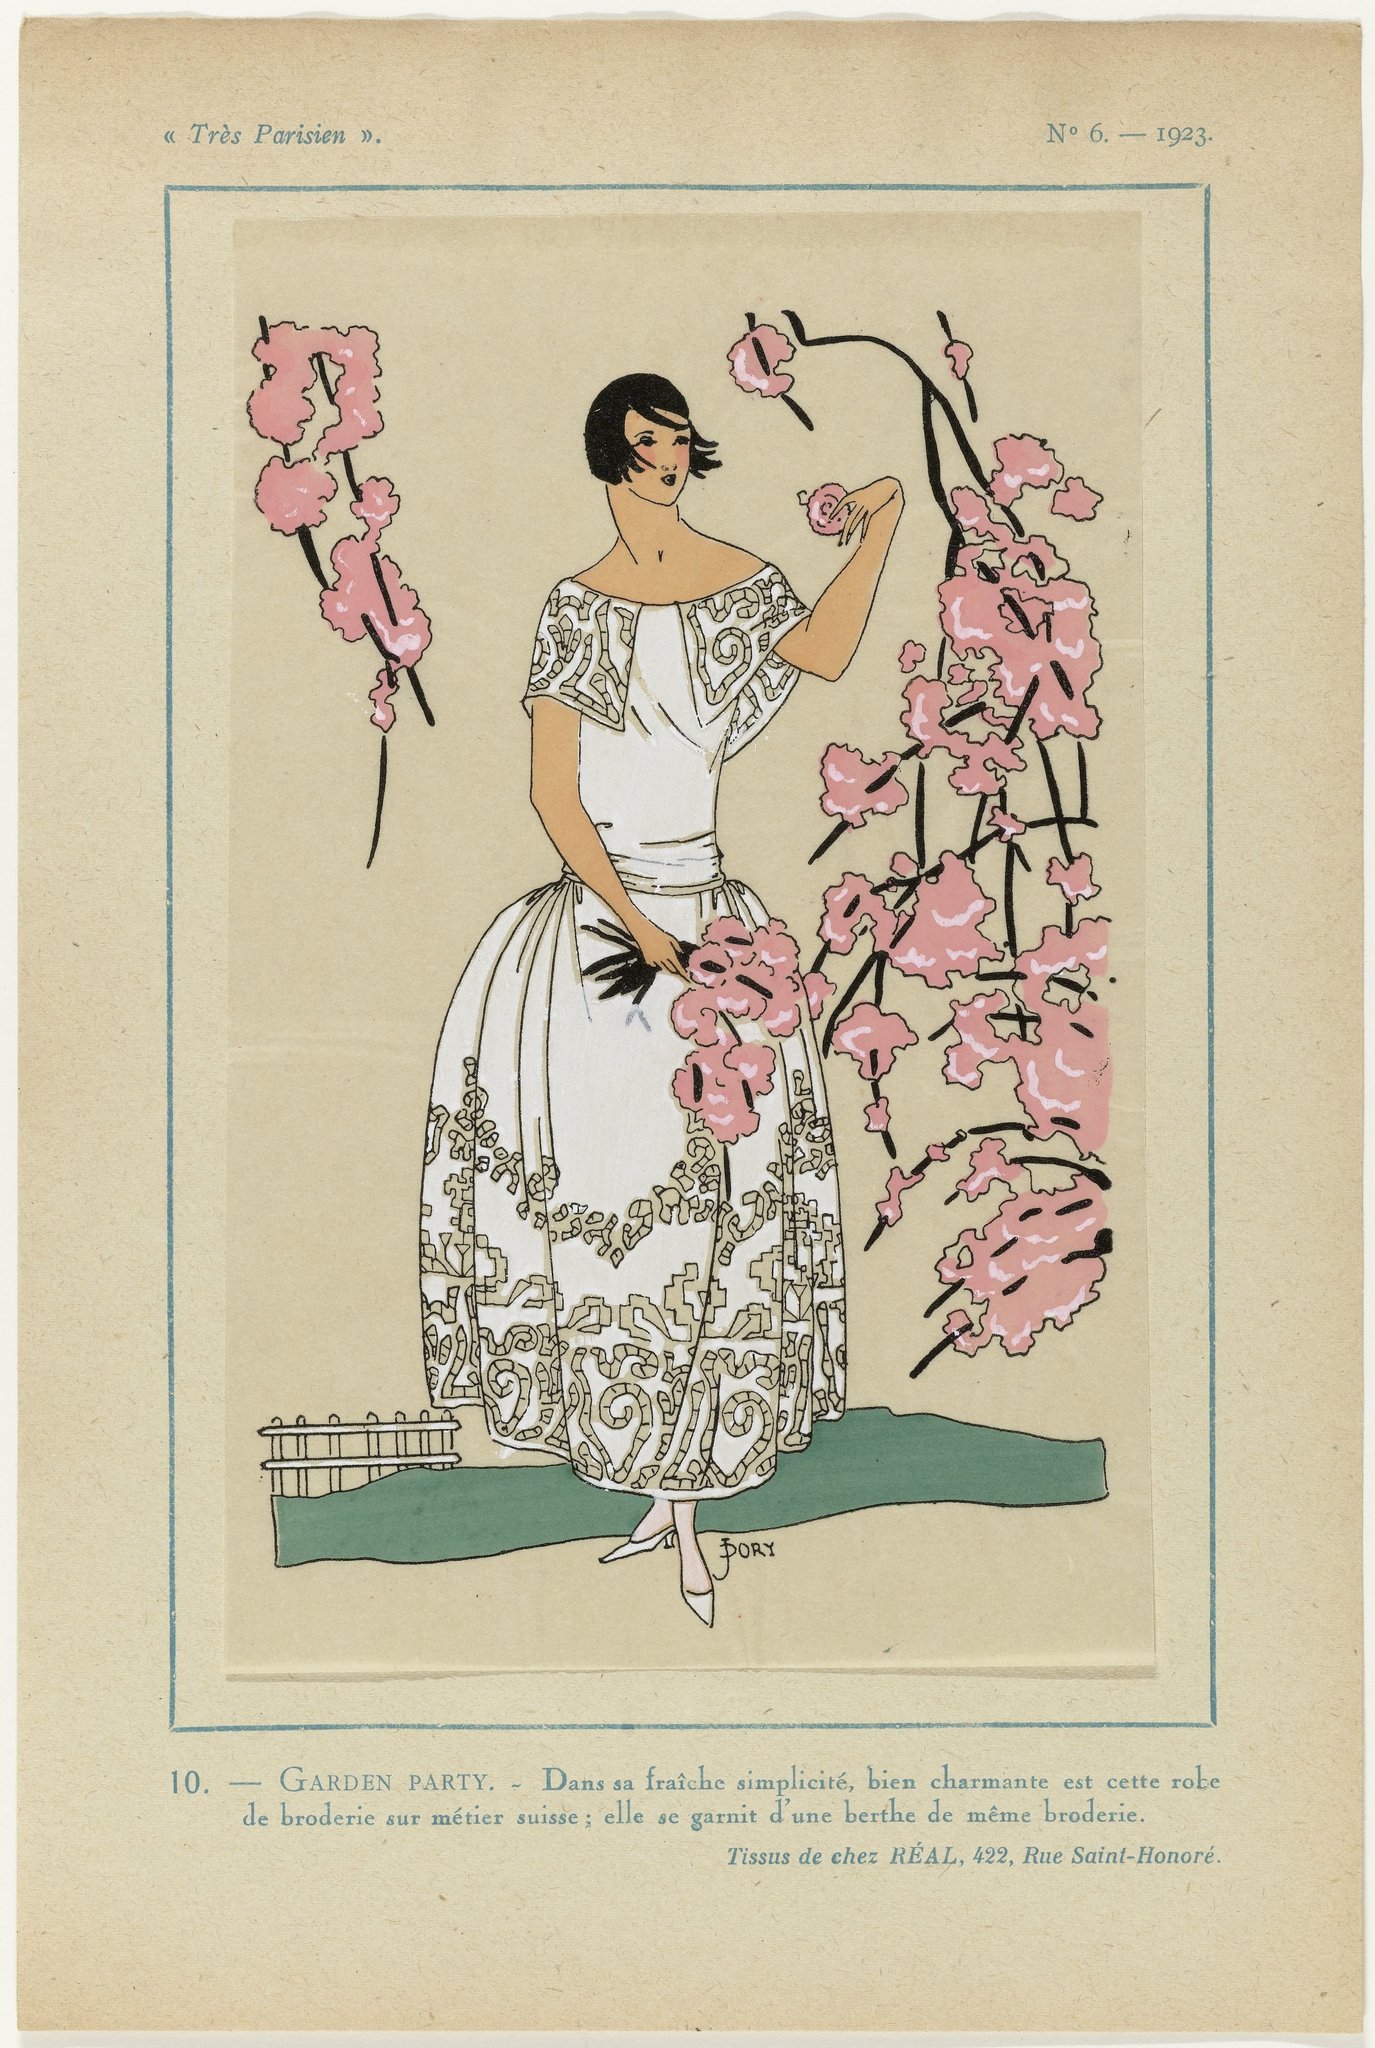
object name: fashion print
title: Très Parisien, 1923, No 6: 10. -GARDEN PARTY. - Dans sa fraîche...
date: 1923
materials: paper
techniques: hand coloring, letterpress printing, lithography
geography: paris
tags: picking flowers, embroidery (ornamentation) (+ women's clothes), neck-gear ~ clothing (bertha) (+ women's clothes), fashion plates, head-gear: hat (+ women's clothes), dress, gown (+ women's clothes)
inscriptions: title: ‘Très Parisien / No 6. - 1923’, caption: ‘10. -GARDEN PARTY. - Dans sa fraîche simplicité, bien charmante est cette robe de broderie sur métier suisse; elle se garnit d'une berthe de même broderie. / Tissus de chez RÉAL, 422, Rue Saint-Honoré.’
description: Garden Party. Jurk met borduurwerk 'op zwitserse wijze'', gegarneerd met een berthe met hetzelfde borduurwerk. Stoffen van Réal. Prent uit het modetijdschrift Très Parisien (1920-1936).